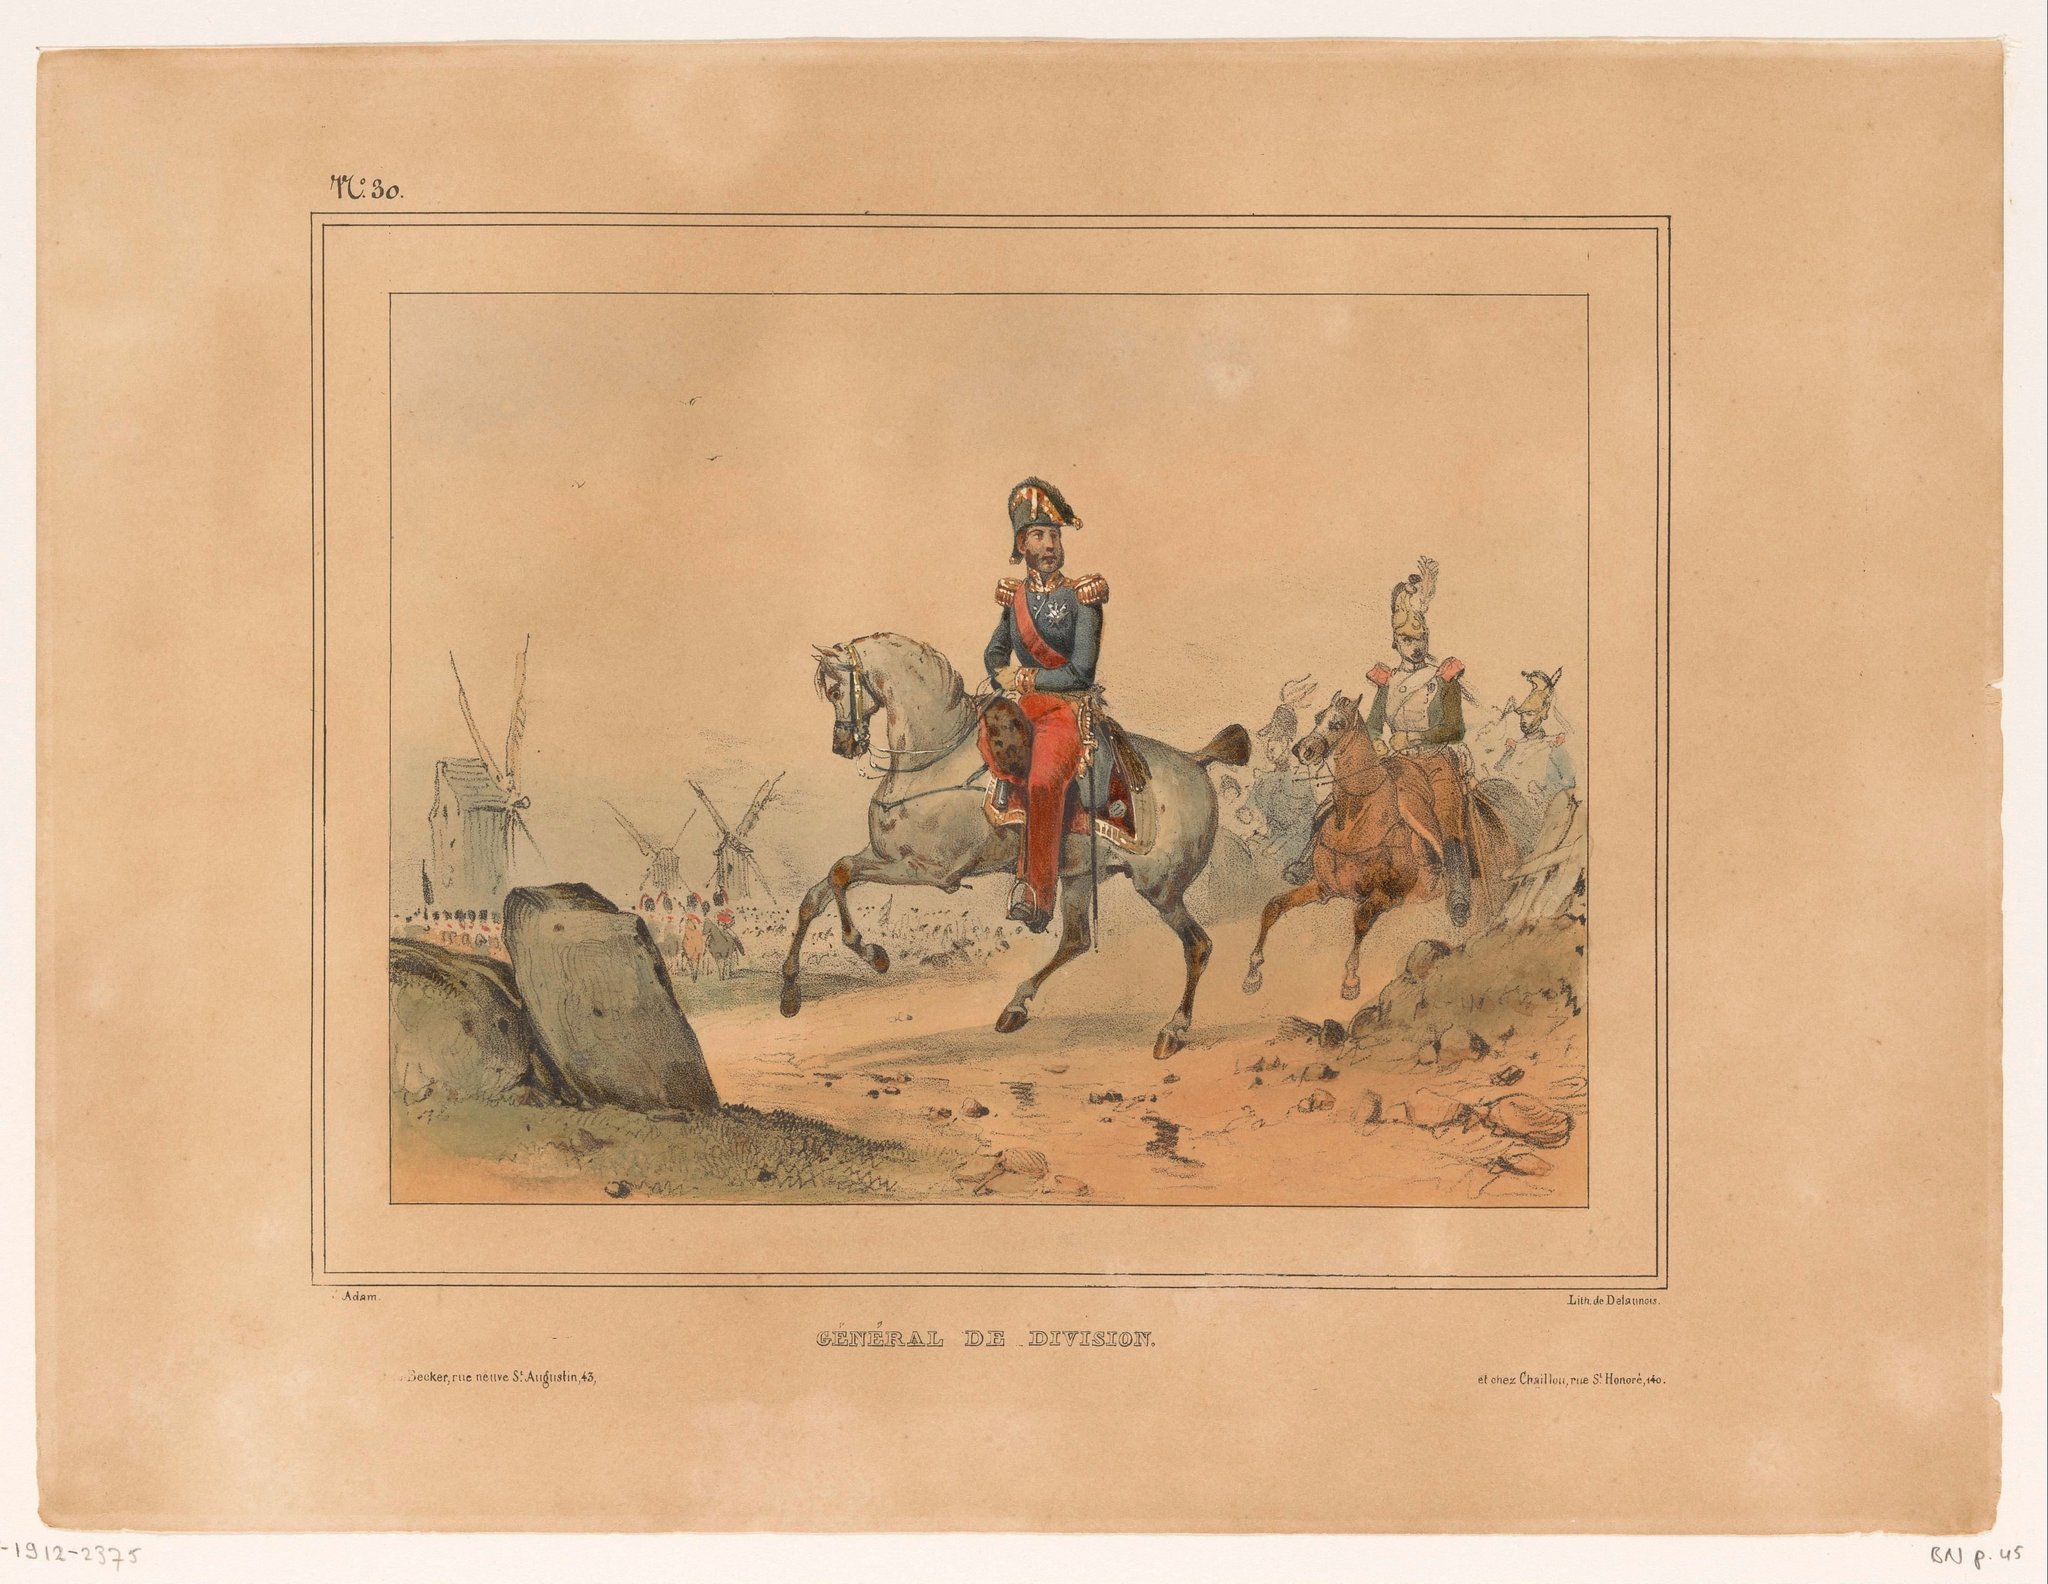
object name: print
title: Collection de costumes militaires, armée française 1832, représentés dans des sujets de genre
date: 1833-1834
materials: paper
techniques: hand coloring, lithograph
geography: paris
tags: ranks in the army, commander-in-chief, general, marshal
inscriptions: collector's mark: Lugt 2228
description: Generaal-majoor en andere militairen van het Franse leger te paard.